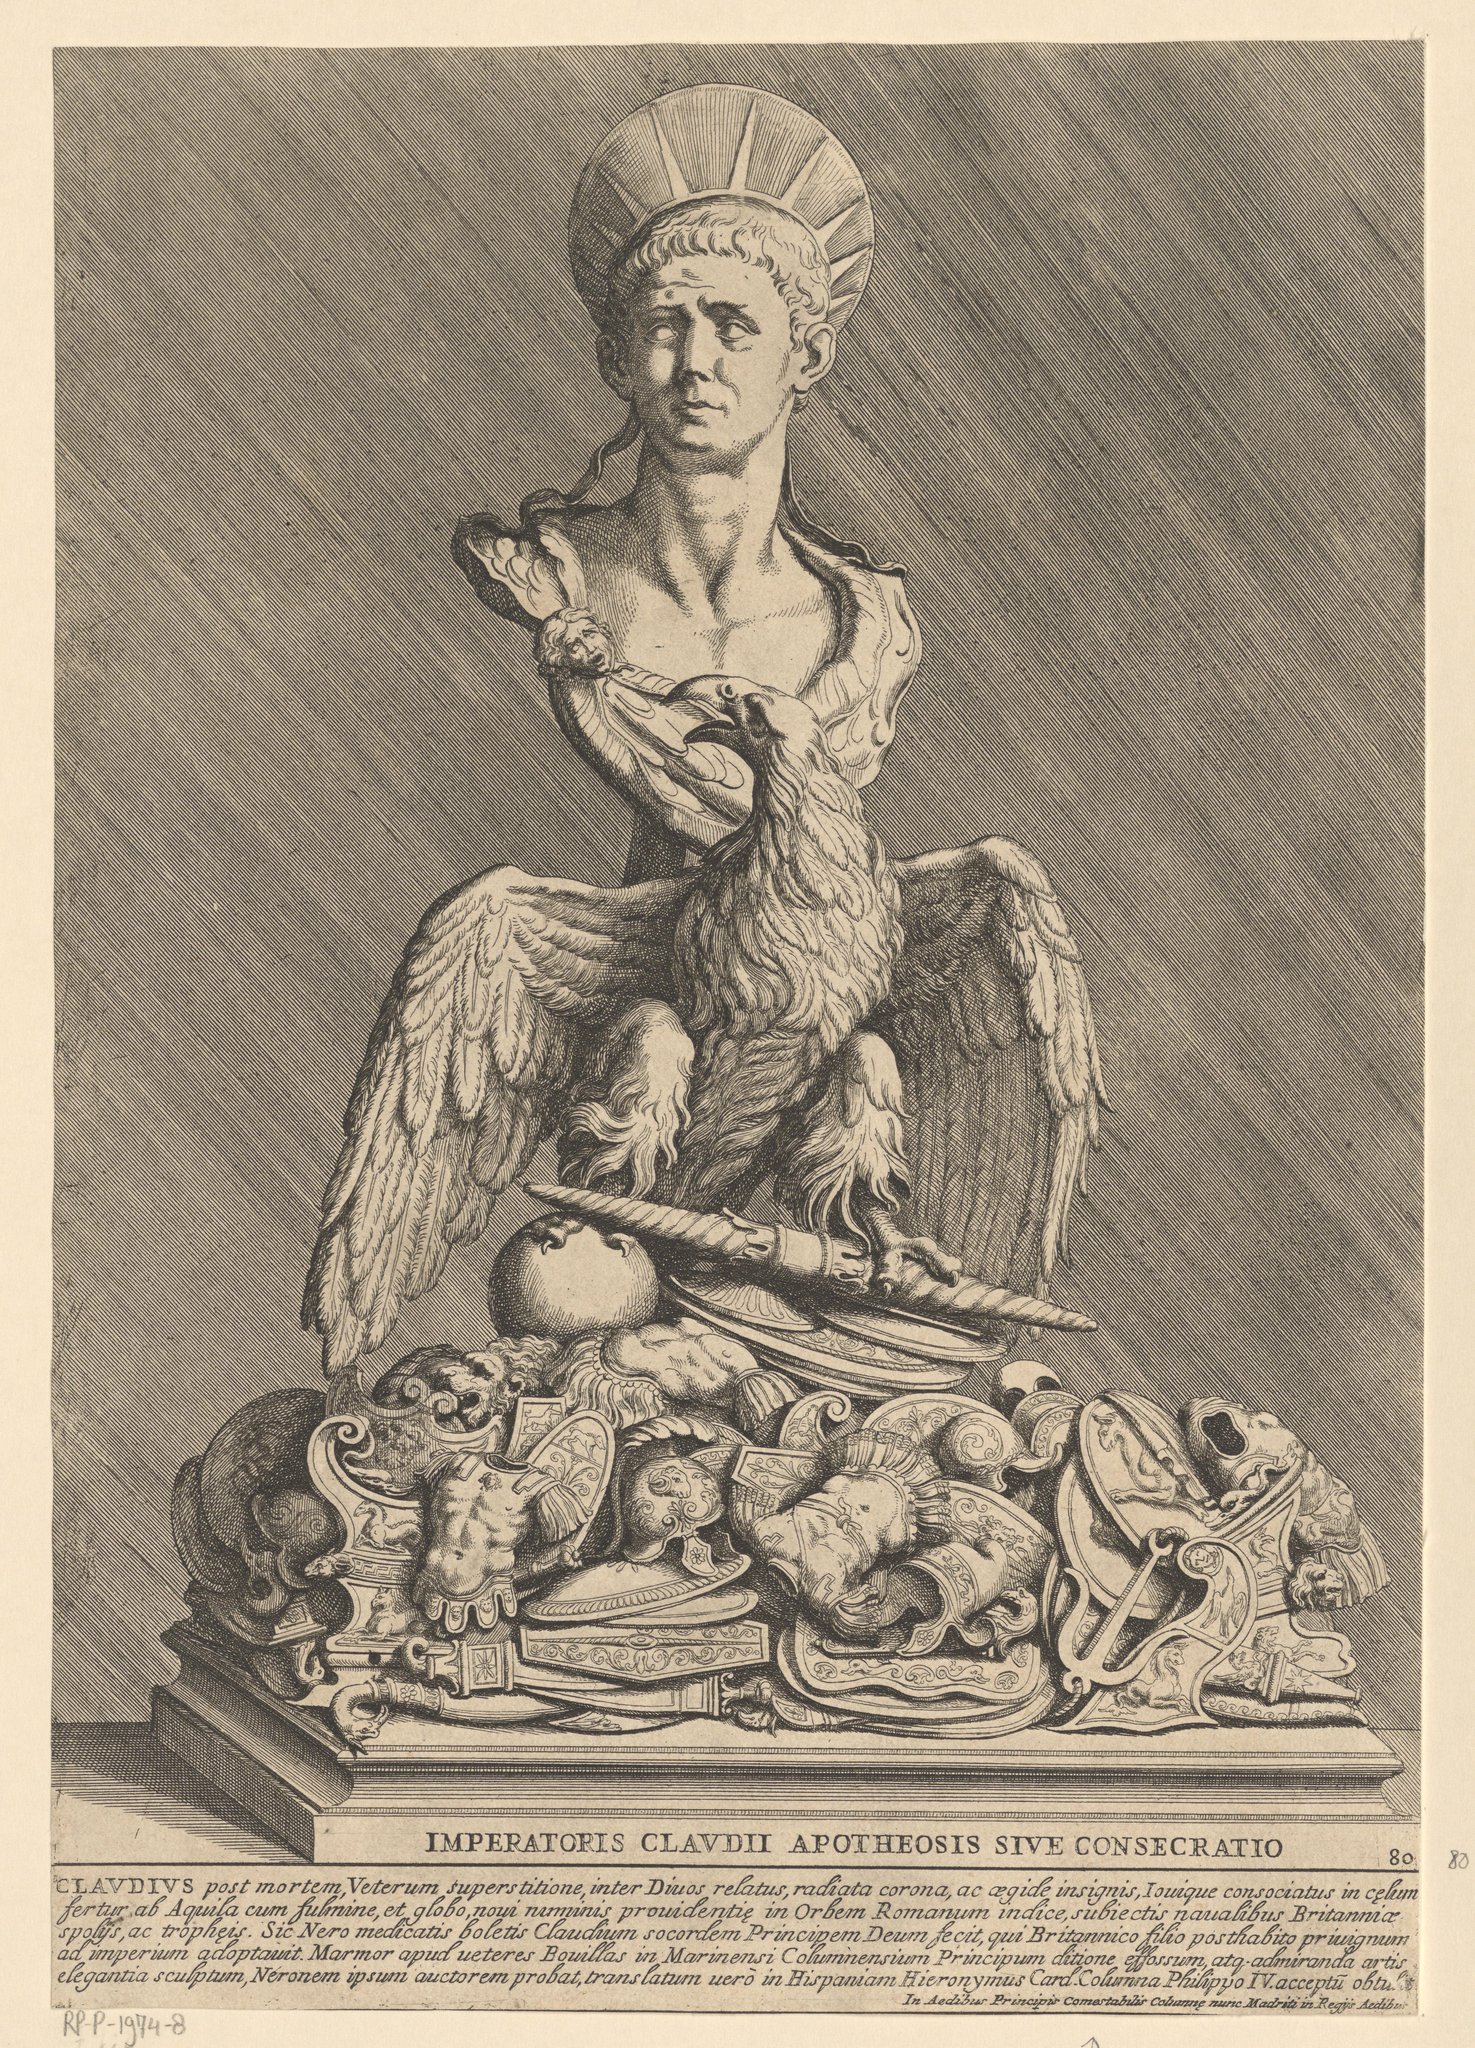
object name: print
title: Admiranda Romanarum Antiquitatum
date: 1657-1693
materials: paper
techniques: engraving, etching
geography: rome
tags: predatory birds: eagle, armour, historical persons, sculpture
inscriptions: collector's mark: Lugt 2760, collector's mark: Lugt 2228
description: Prent maakt onderdeel uit van een serie van 83 prenten over het oude Rome, die is uitgegeven in 1657,1677 en 1693.